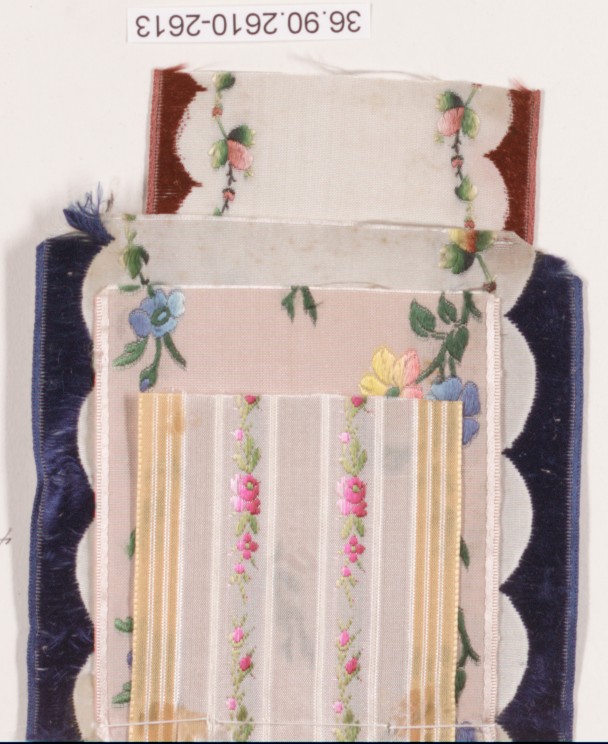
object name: ribbon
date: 1801-1900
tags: flowers